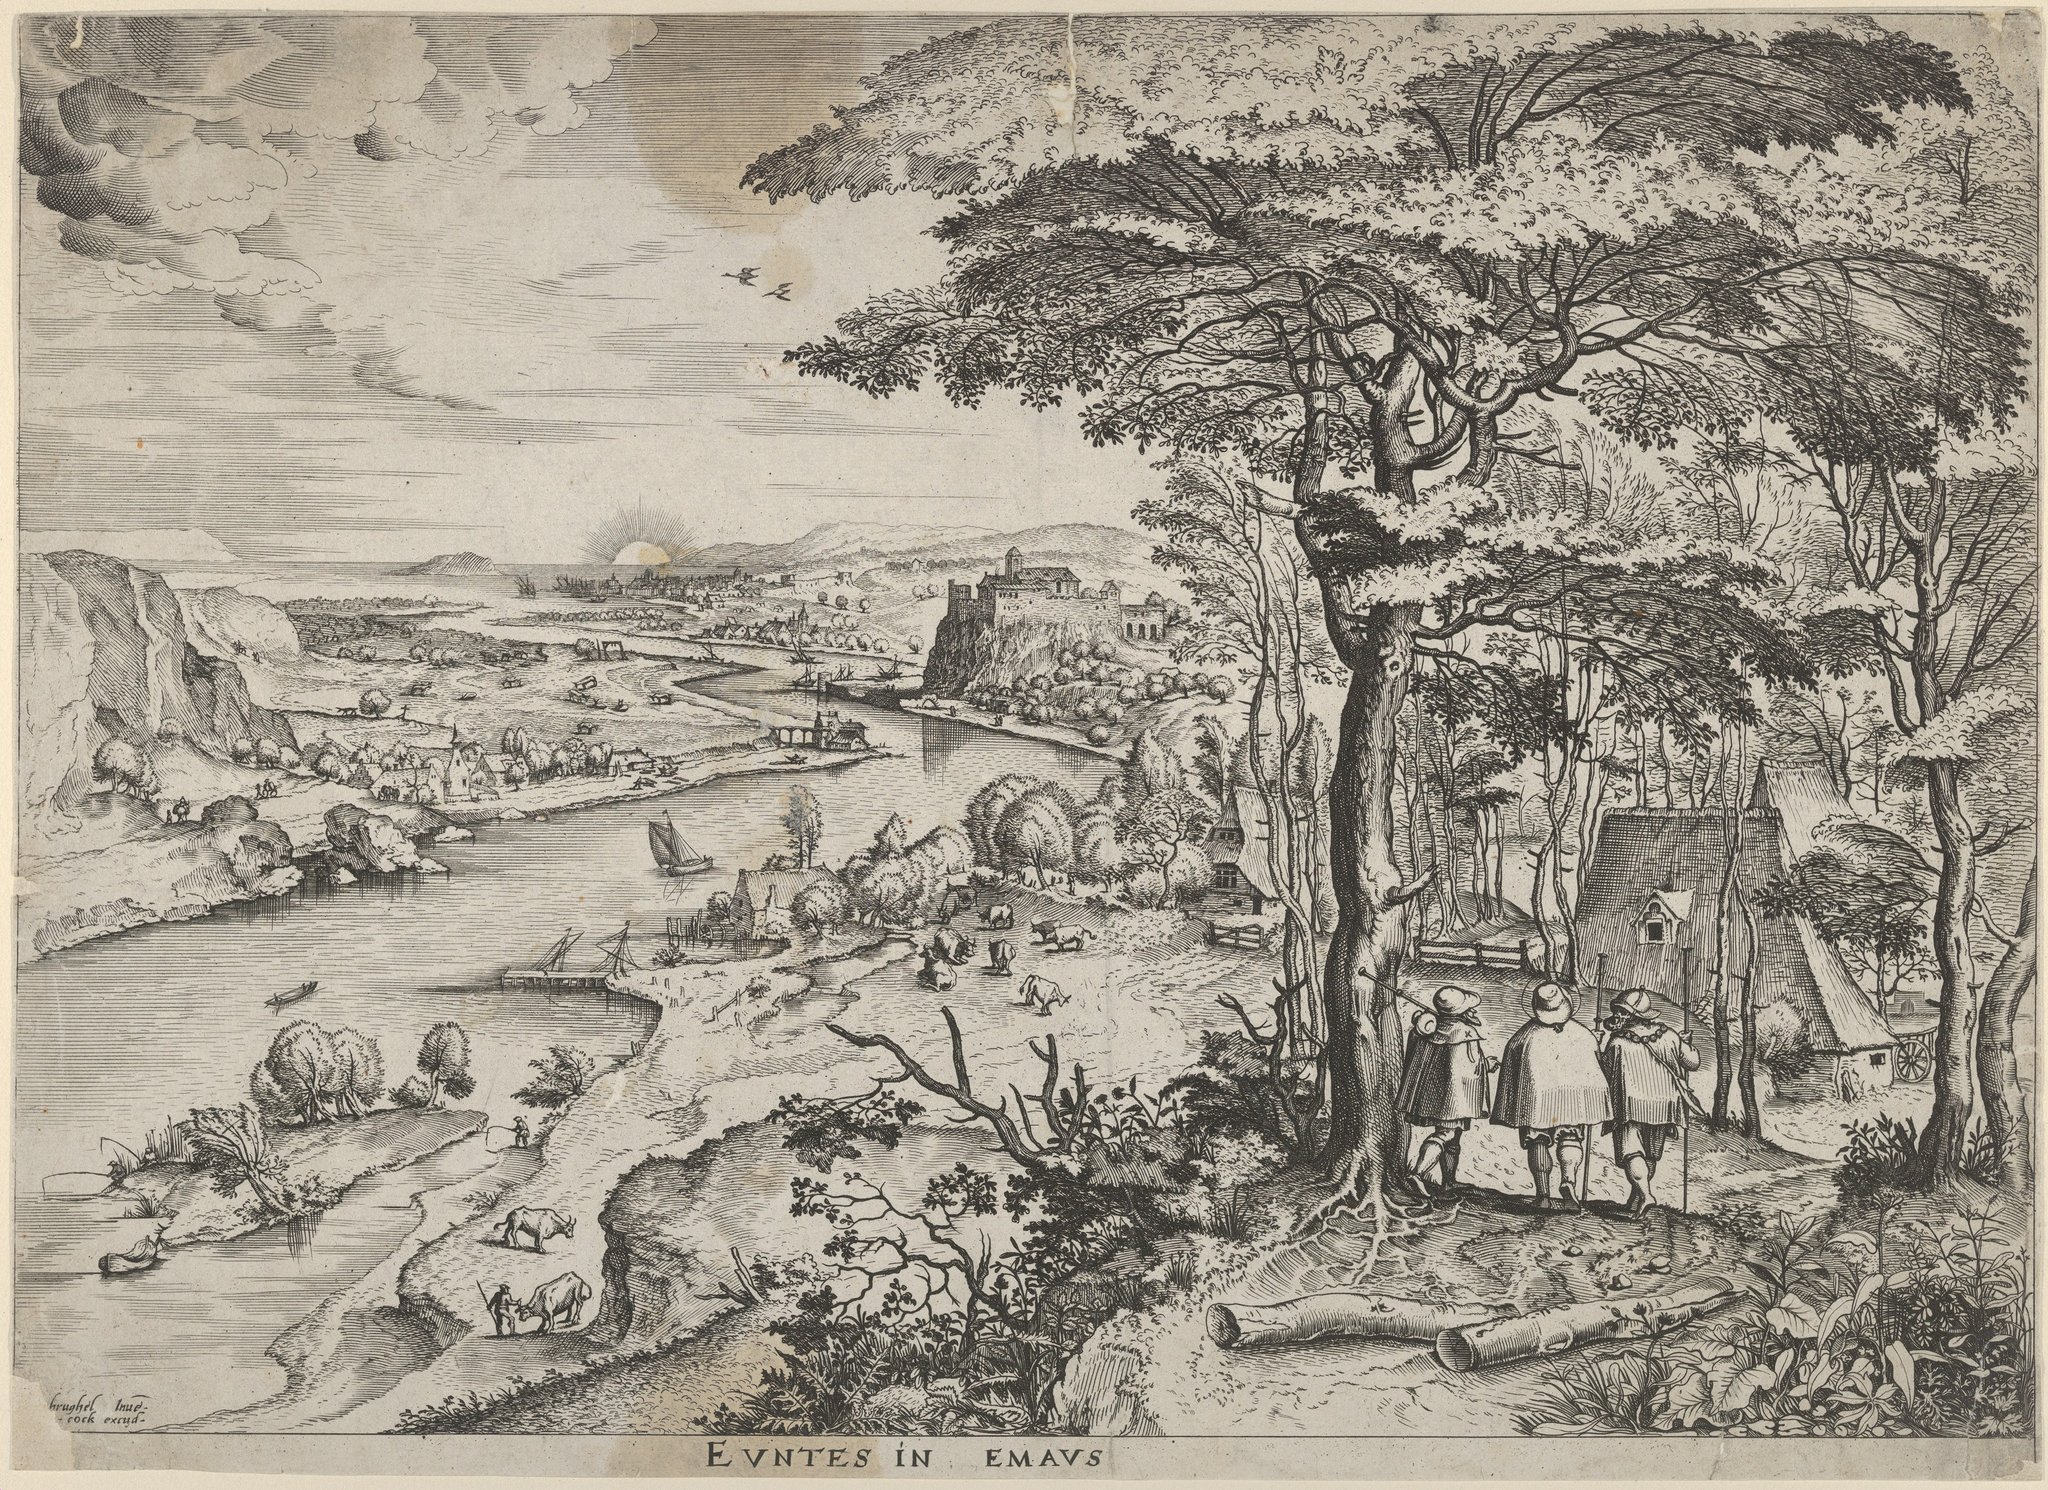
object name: print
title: Euntes in Emaus (Landscape with Pilgrims at Emmaus)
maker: pieter bruegel the elder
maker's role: artist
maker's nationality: netherlandish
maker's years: 1525-1569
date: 1555-1556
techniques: engraving, etching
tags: rivers,landscapes